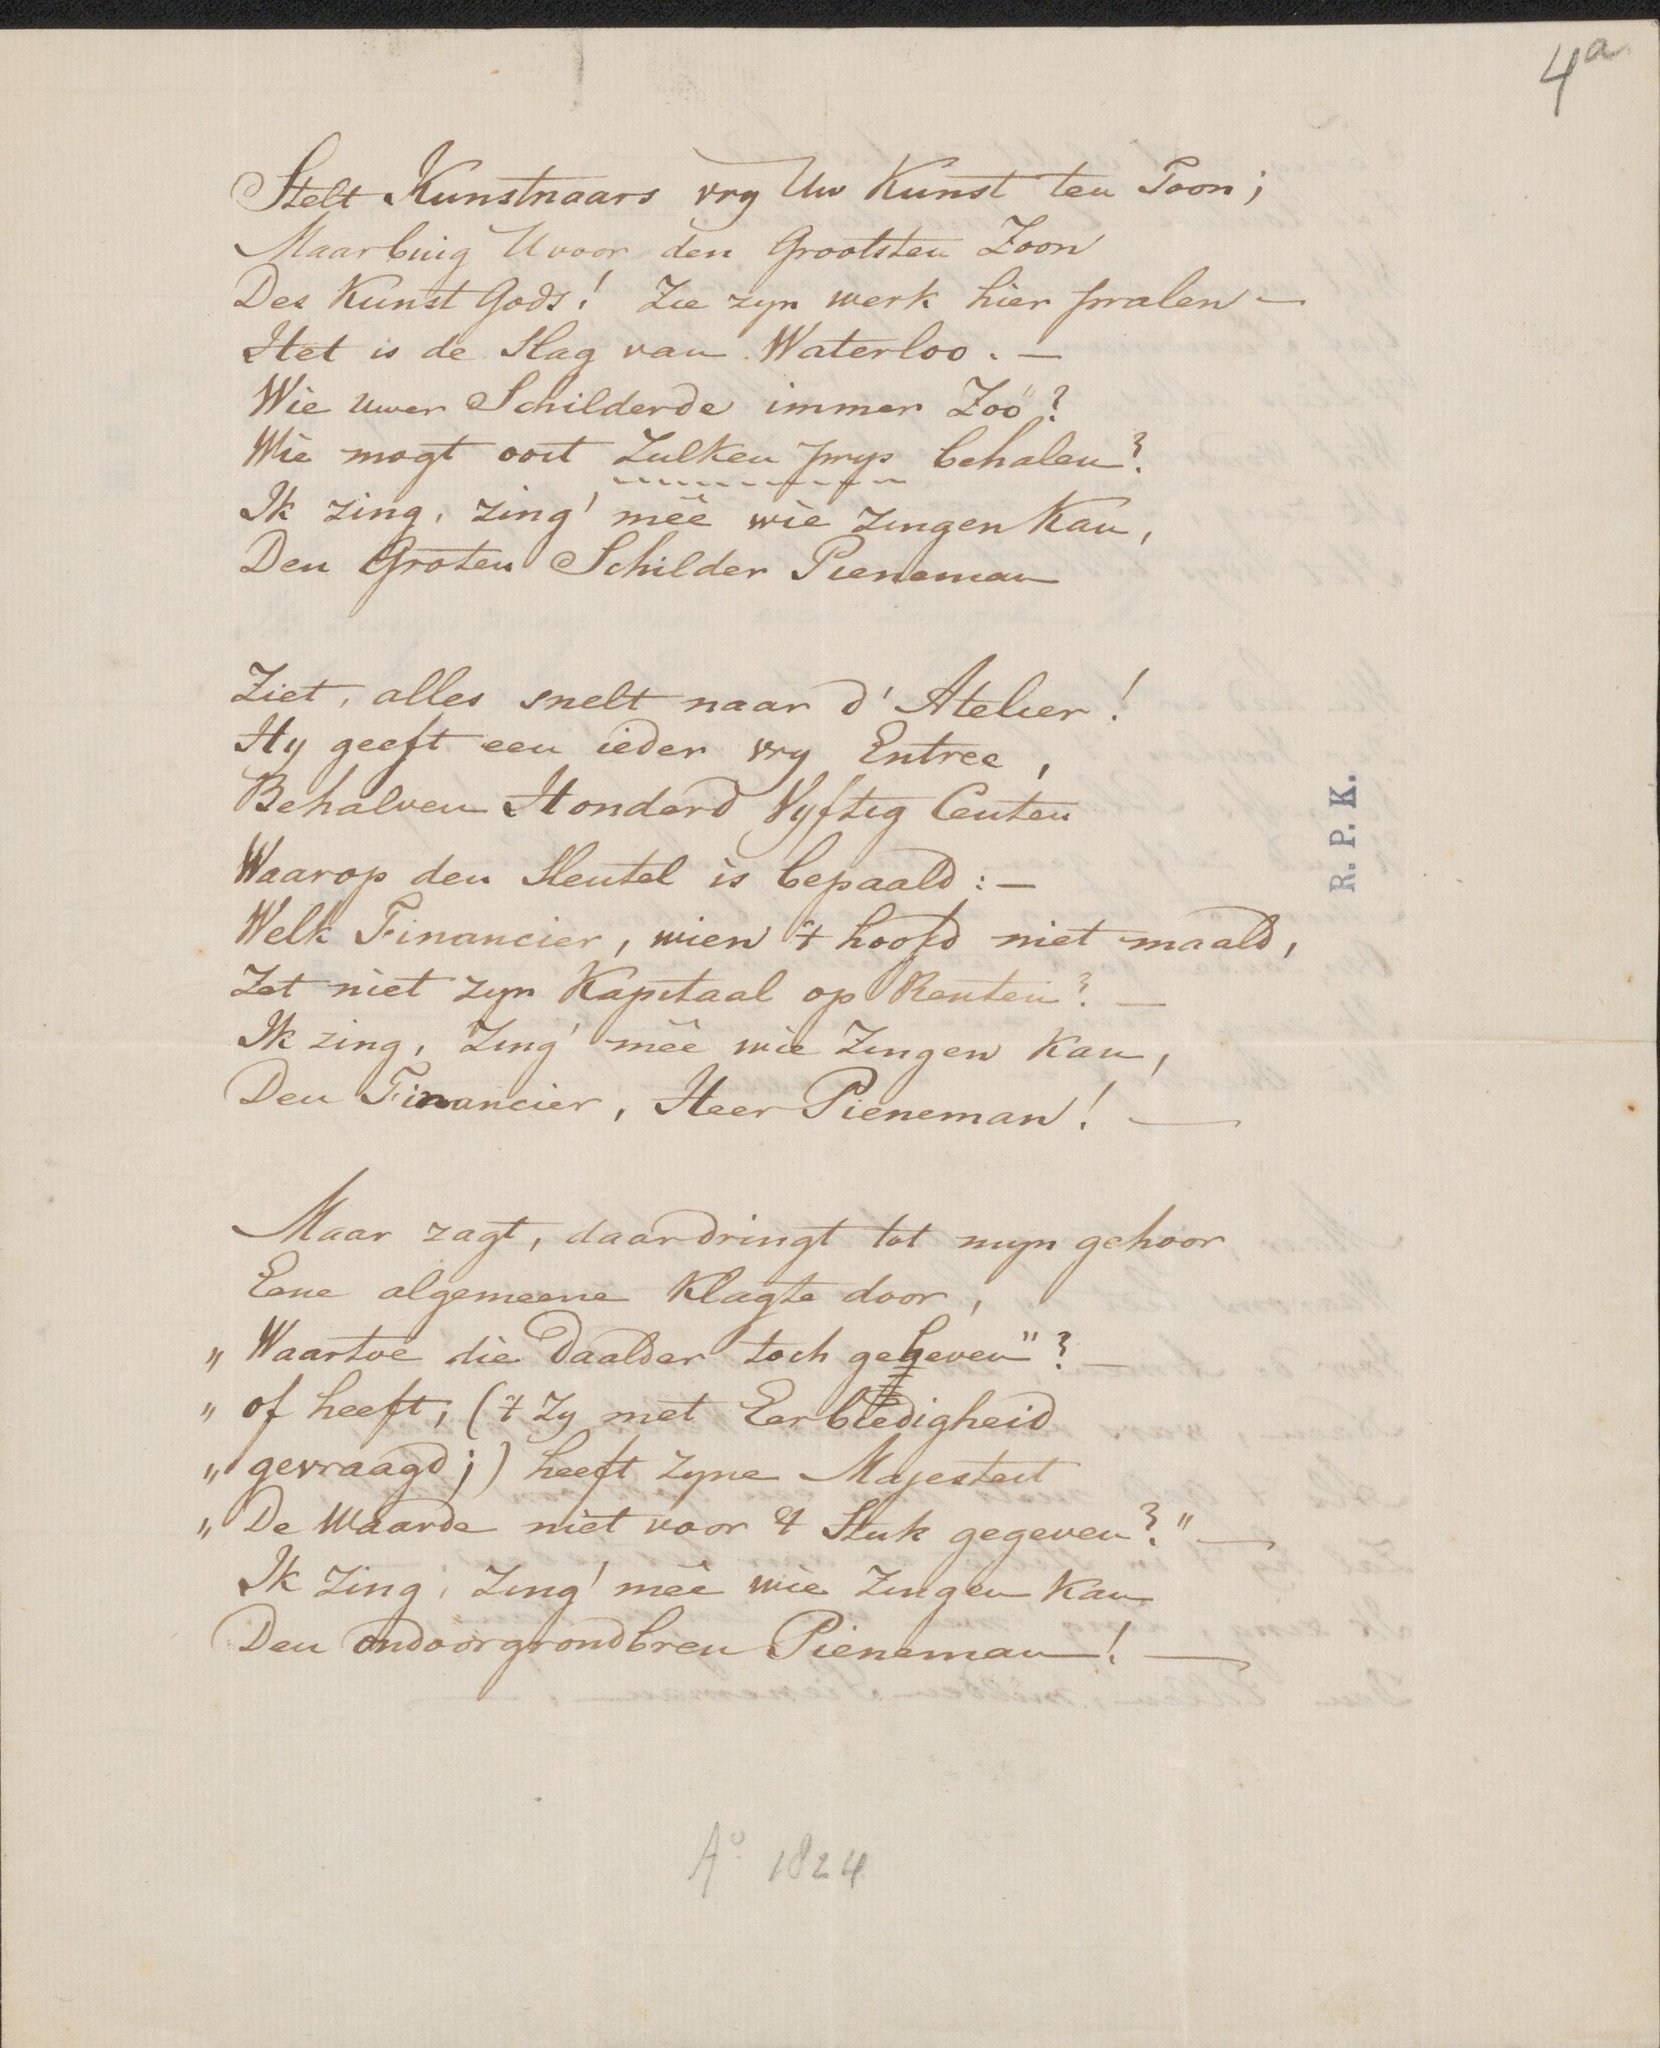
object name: poem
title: Gedicht over de Slag bij Waterloo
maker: Anonymous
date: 1789-1853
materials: ink, paper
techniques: pen, writing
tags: abcoude, amsterdam, painter, jan willem pieneman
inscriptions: watermark, collector's mark: Lugt 2233